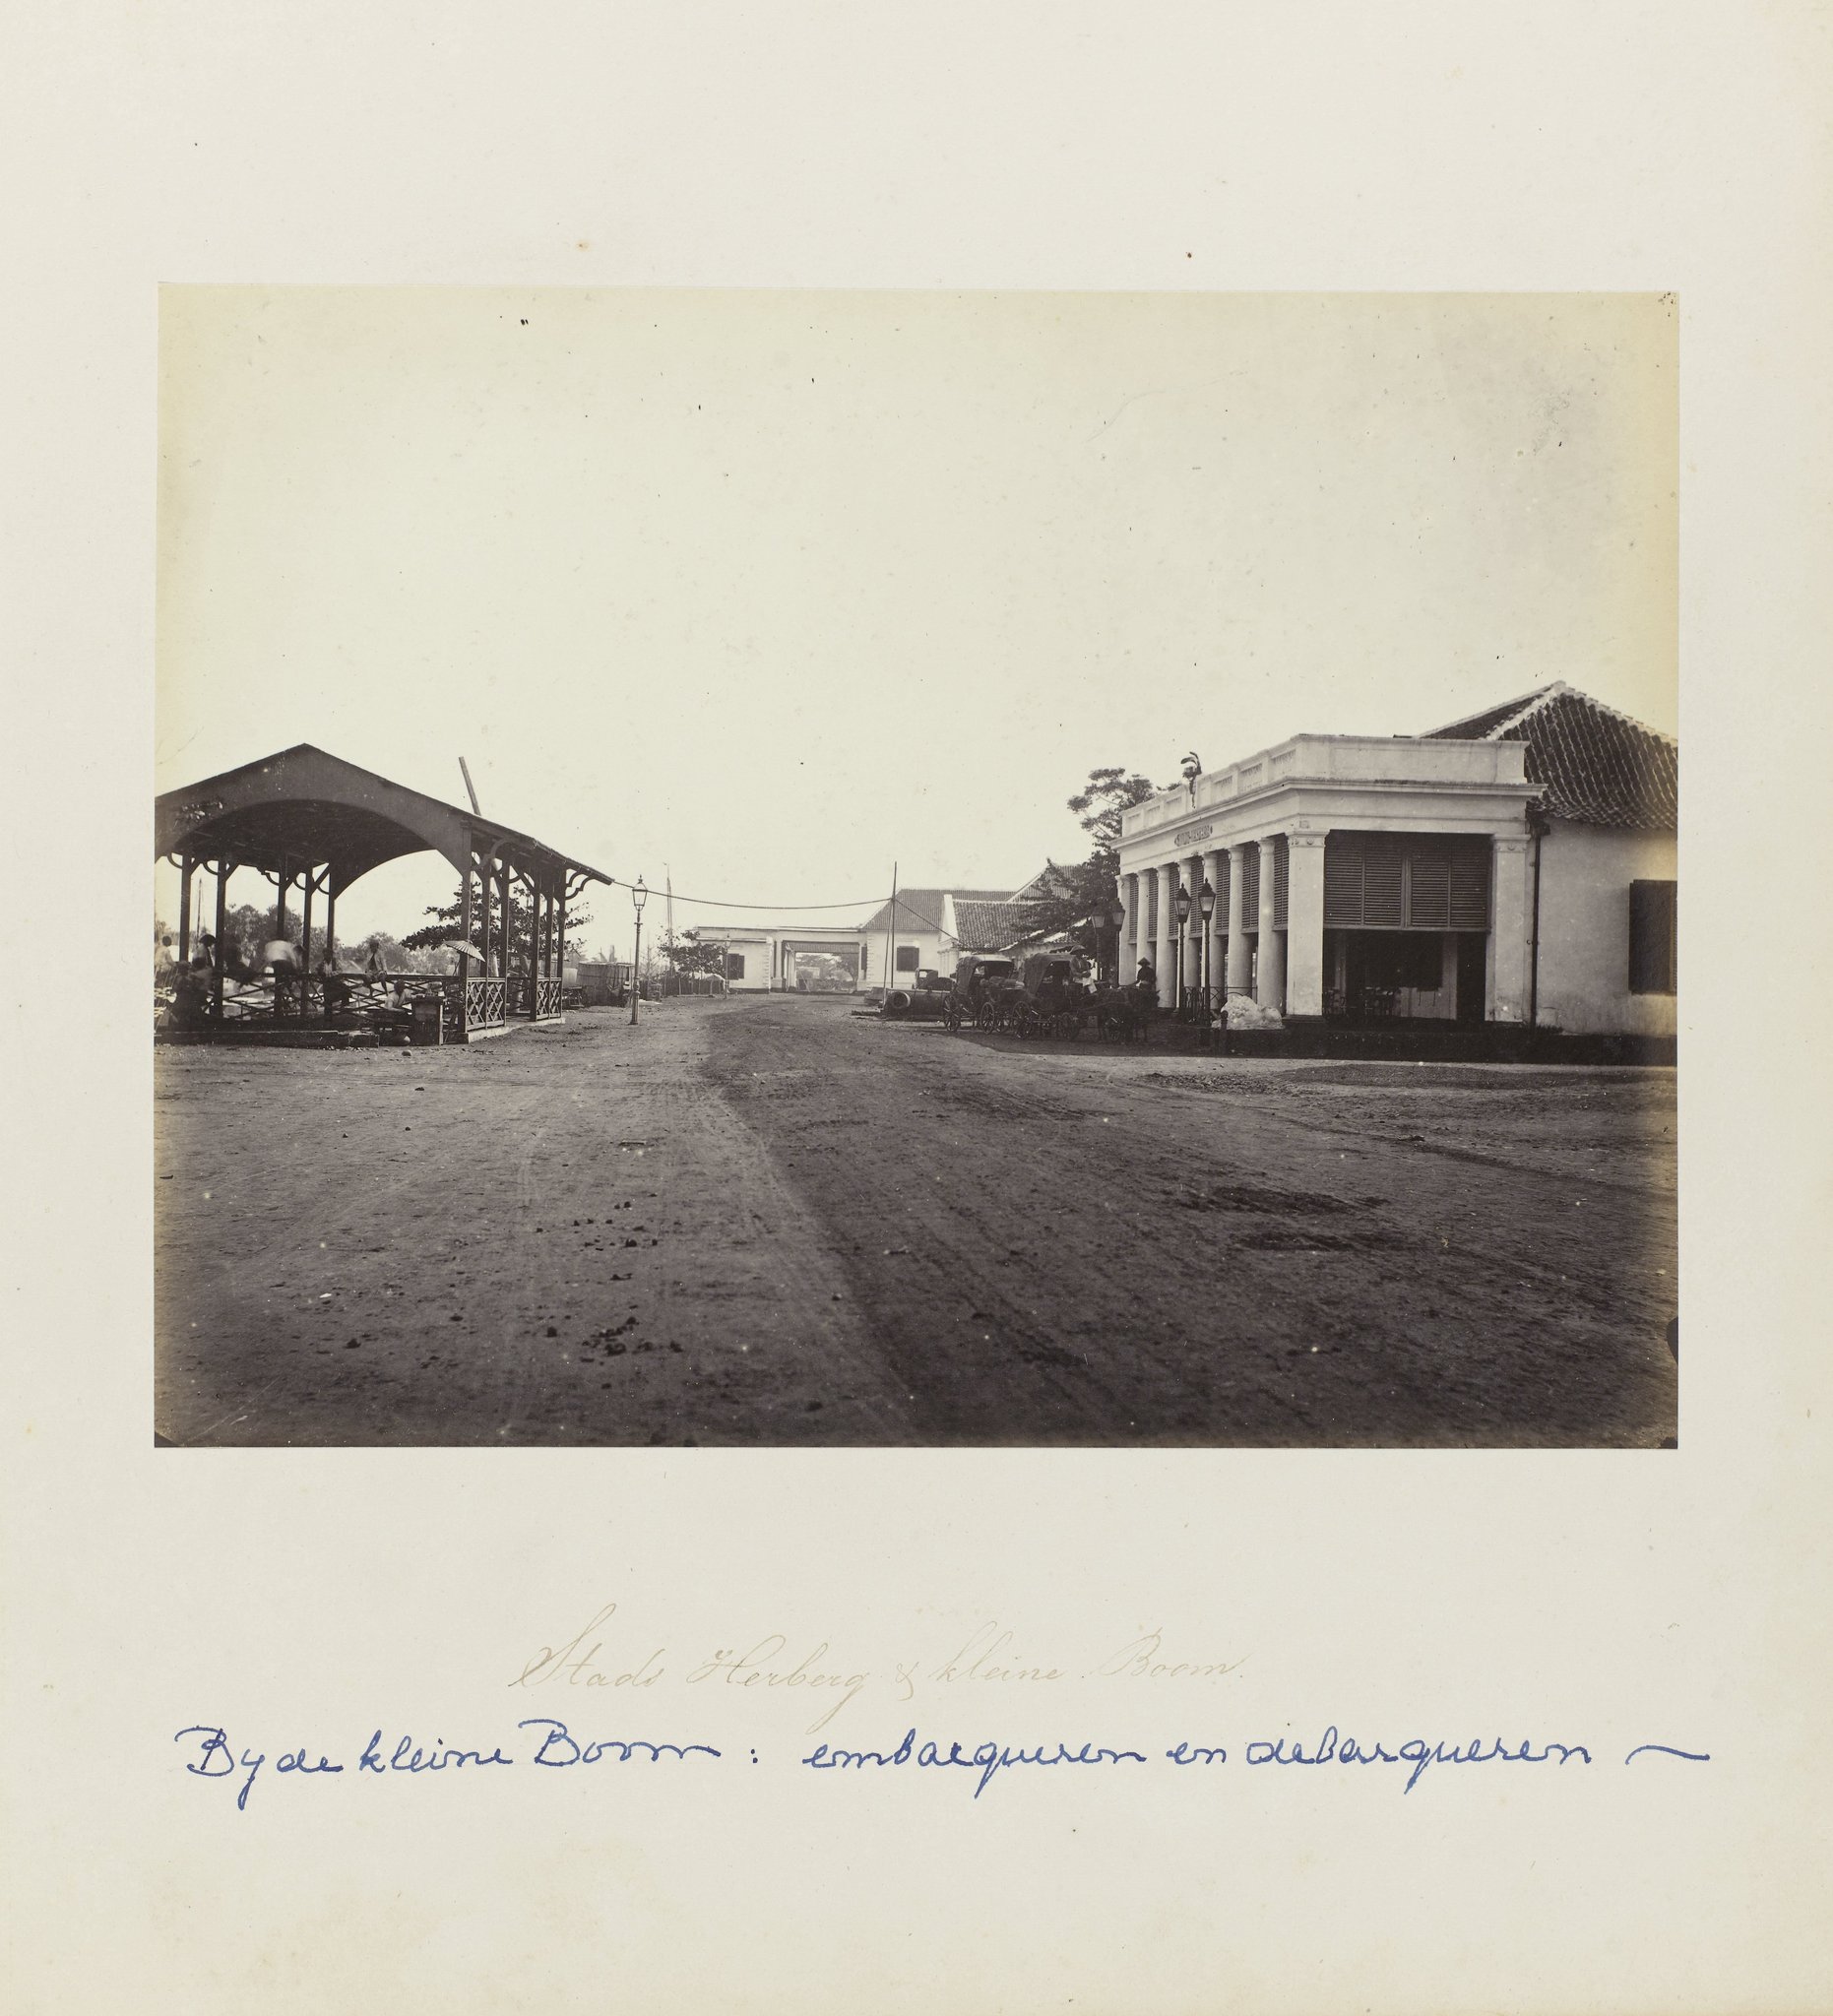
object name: photograph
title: Stads Herberg & kleine Boom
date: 1863-1866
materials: photographic support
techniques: albumen print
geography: batavia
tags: warehouse (~ harbour), batavia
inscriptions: inscription: ‘Bij de kleine Boom: embarqueren en debarqueren’, inscription: ‘Stads Herberg & kleine Boom’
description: Gezicht op de gebouwen van de Stadsherberg en de Kleine Boom te Batavia. Onderdeel van het rode fotoalbum met foto's van Java, uit het bezit van apotheker Specht-Grijp, die in 1865 vanuit Batavia naar Nederland terugkeerde.